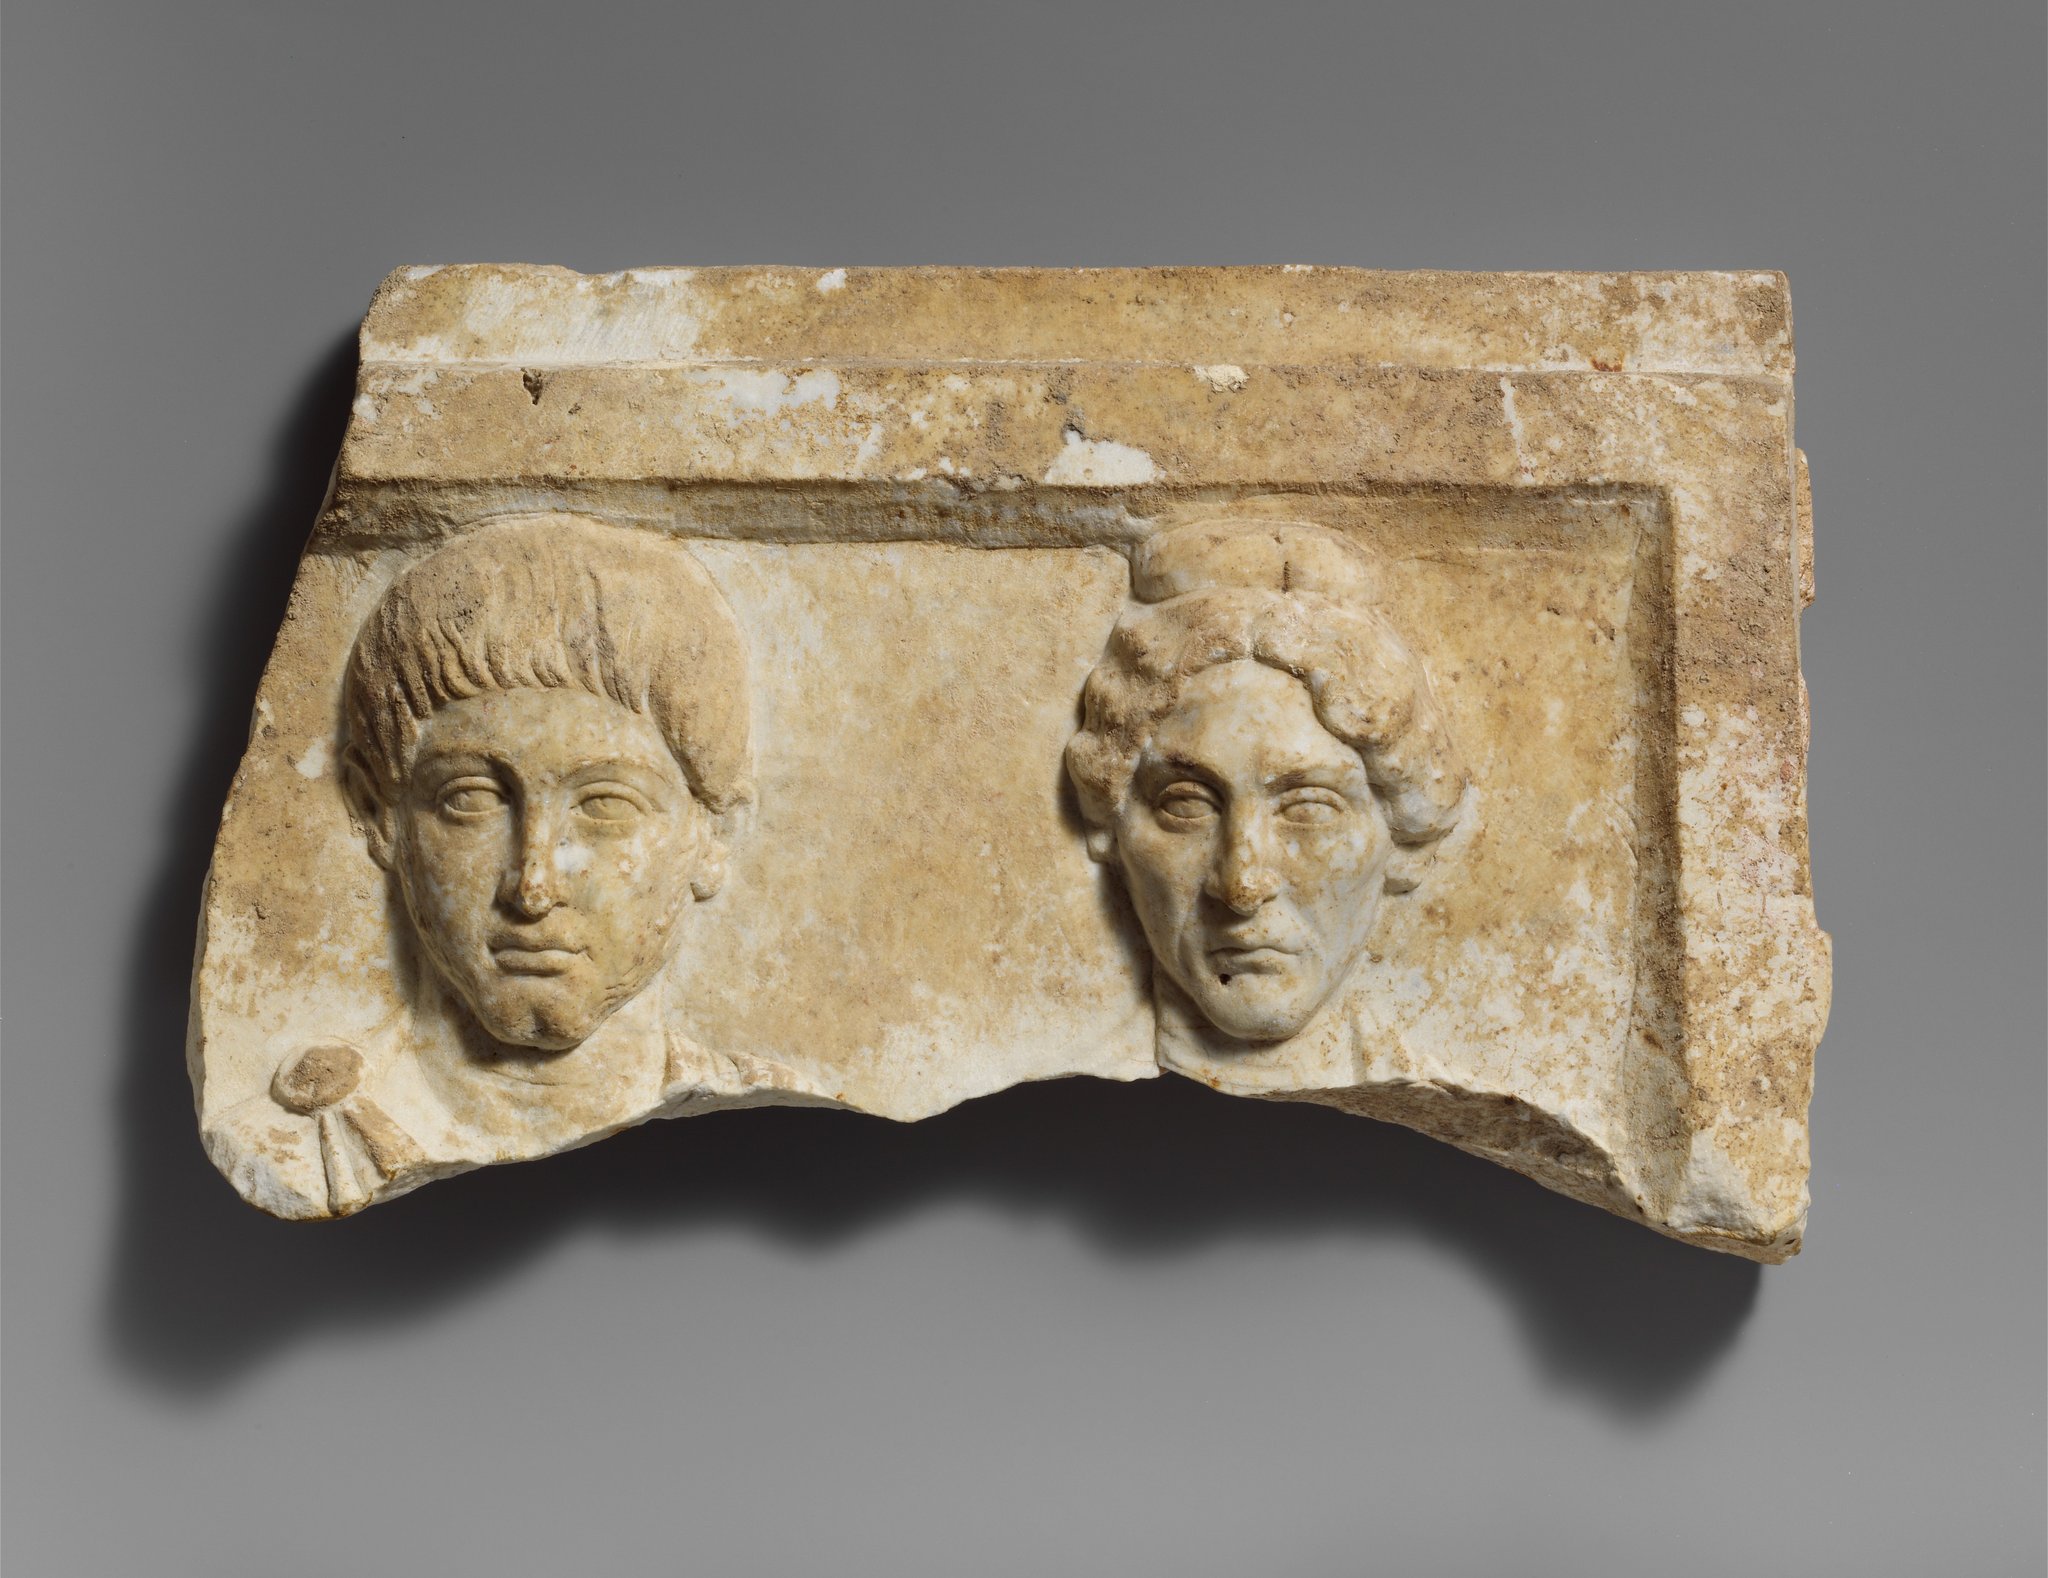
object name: grave relief fragment, portrait of young man and elderly woman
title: Top of a marble funerary relief with portrait busts of a young man and an elderly woman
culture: roman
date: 138-141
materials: marble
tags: heads,men,women